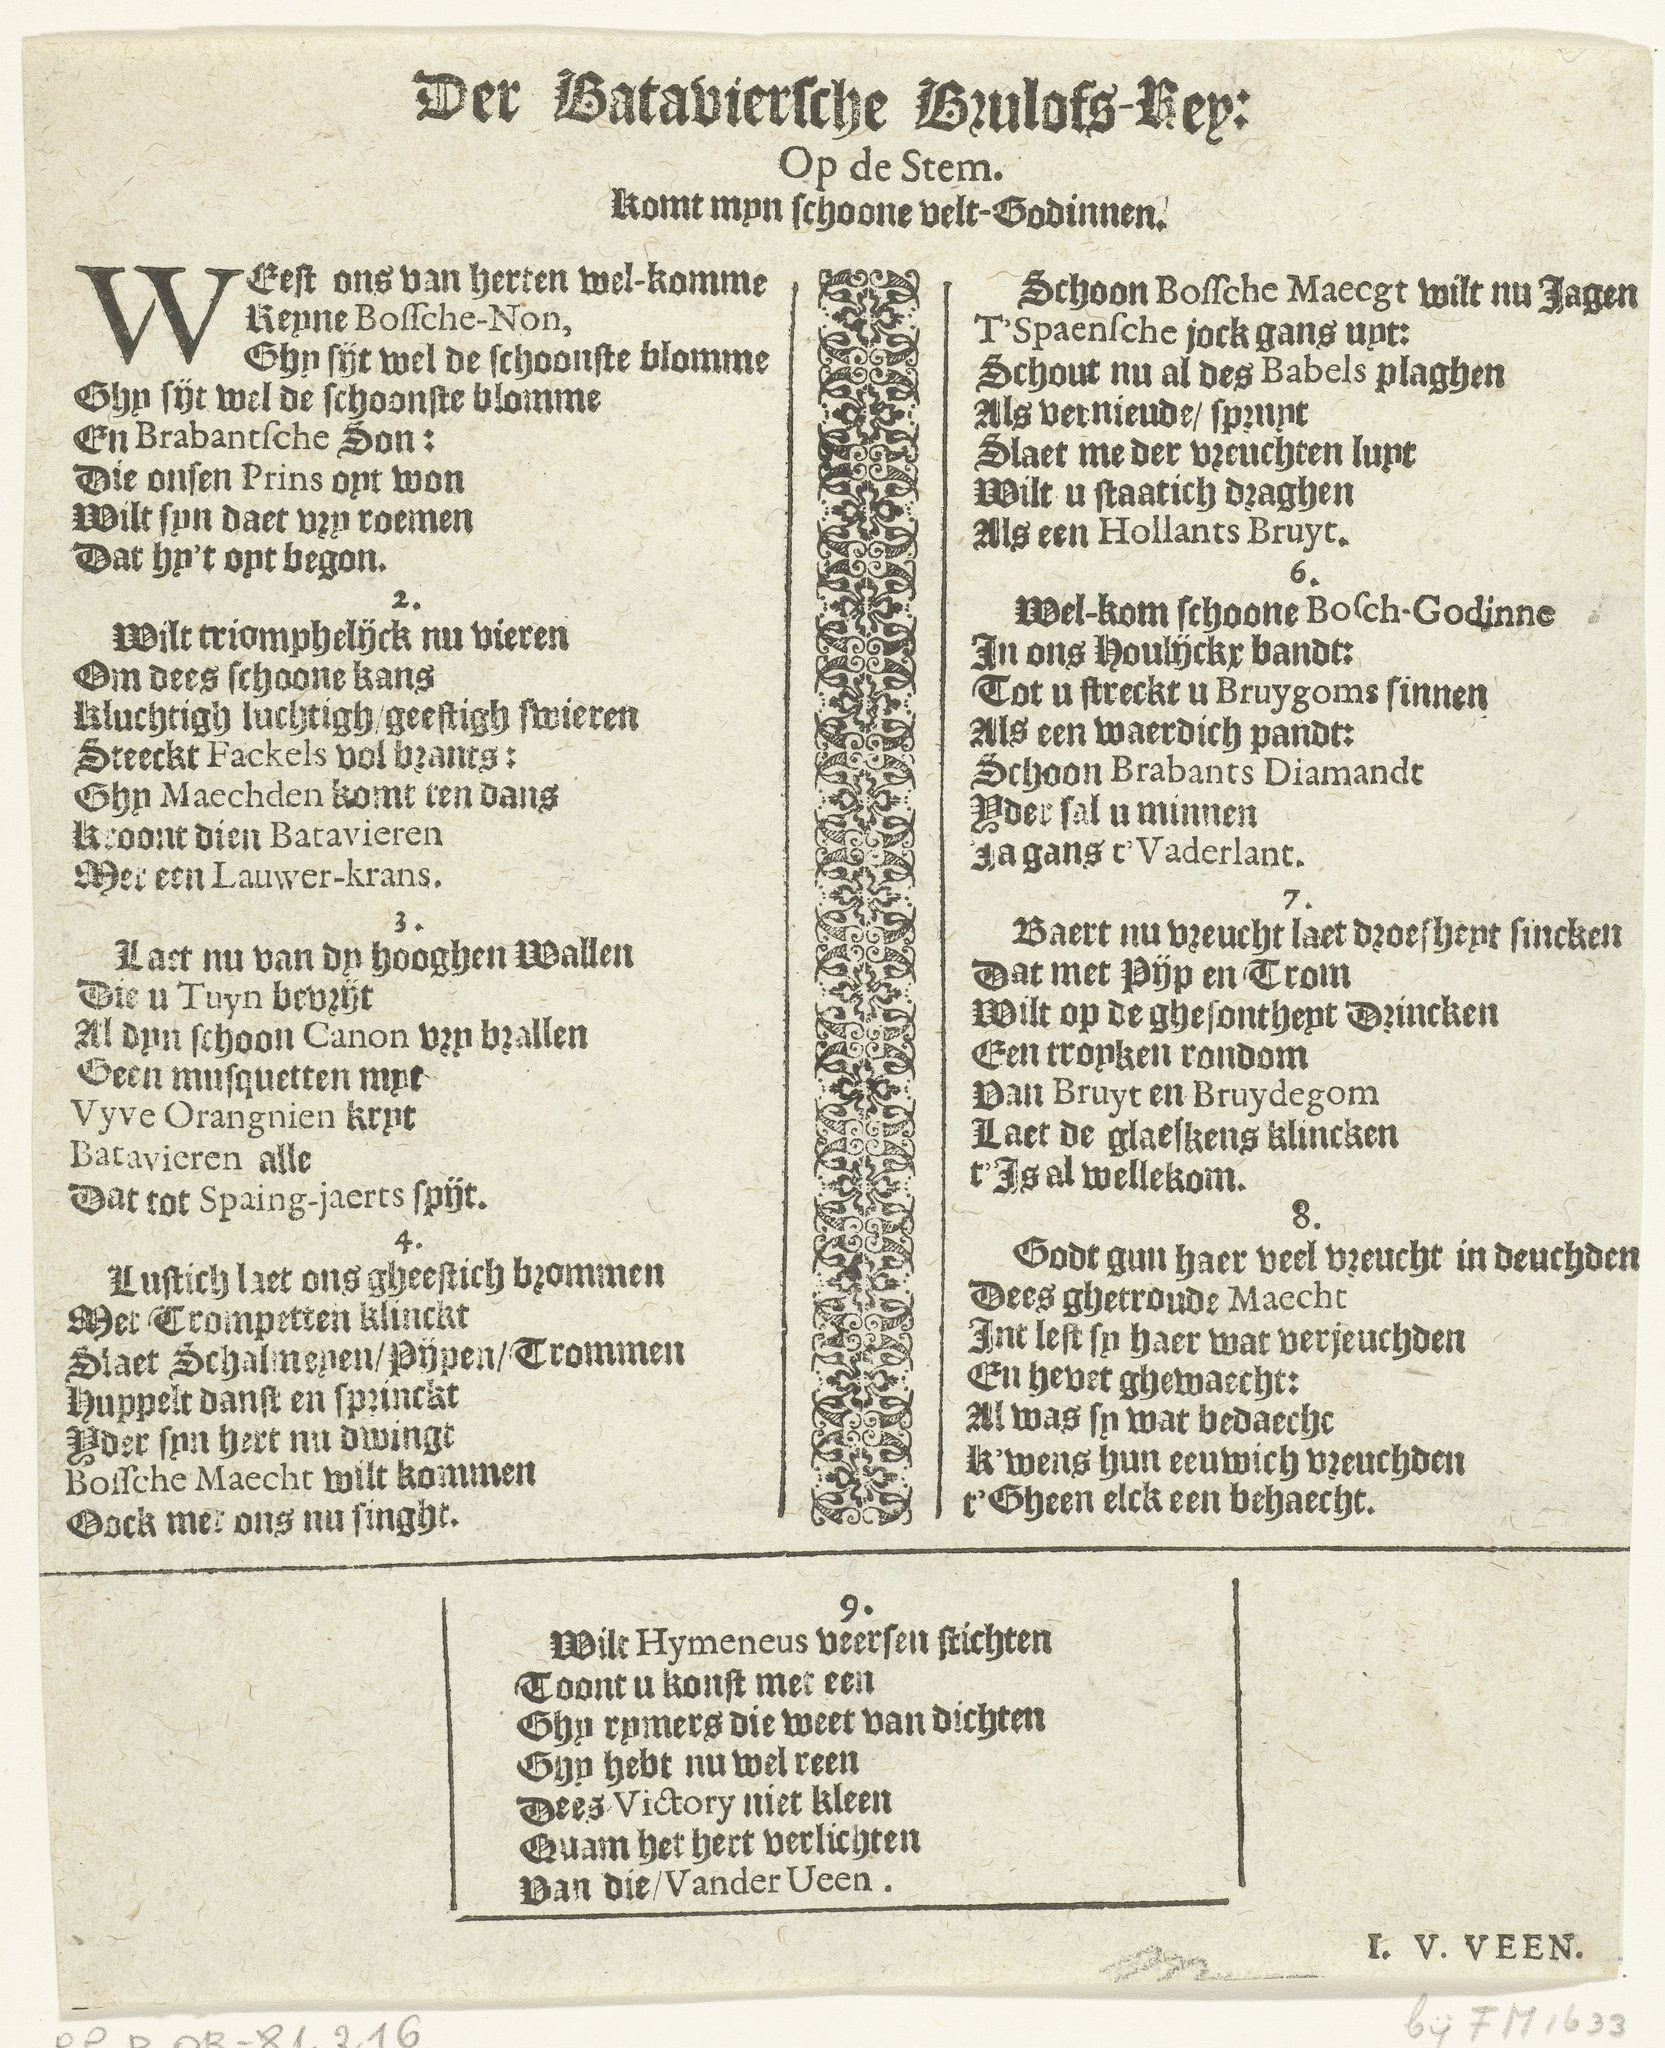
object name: text sheet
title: Lied ter ere van de verovering van 's-Hertogenbosch door Frederik Hendrik, 1629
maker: jan van der veen (dichter)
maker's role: dichter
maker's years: 1578-1659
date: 1629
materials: paper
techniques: letterpress printing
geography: northern netherlands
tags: delft, the hague, frederick henry (prince of orange), den bosch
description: Lied ter ere van de verovering van 's-Hertogenbosch door Frederik Hendrik op 17 september 1629. Lied in 9 verzen in twee kolommen in het Nederlands.